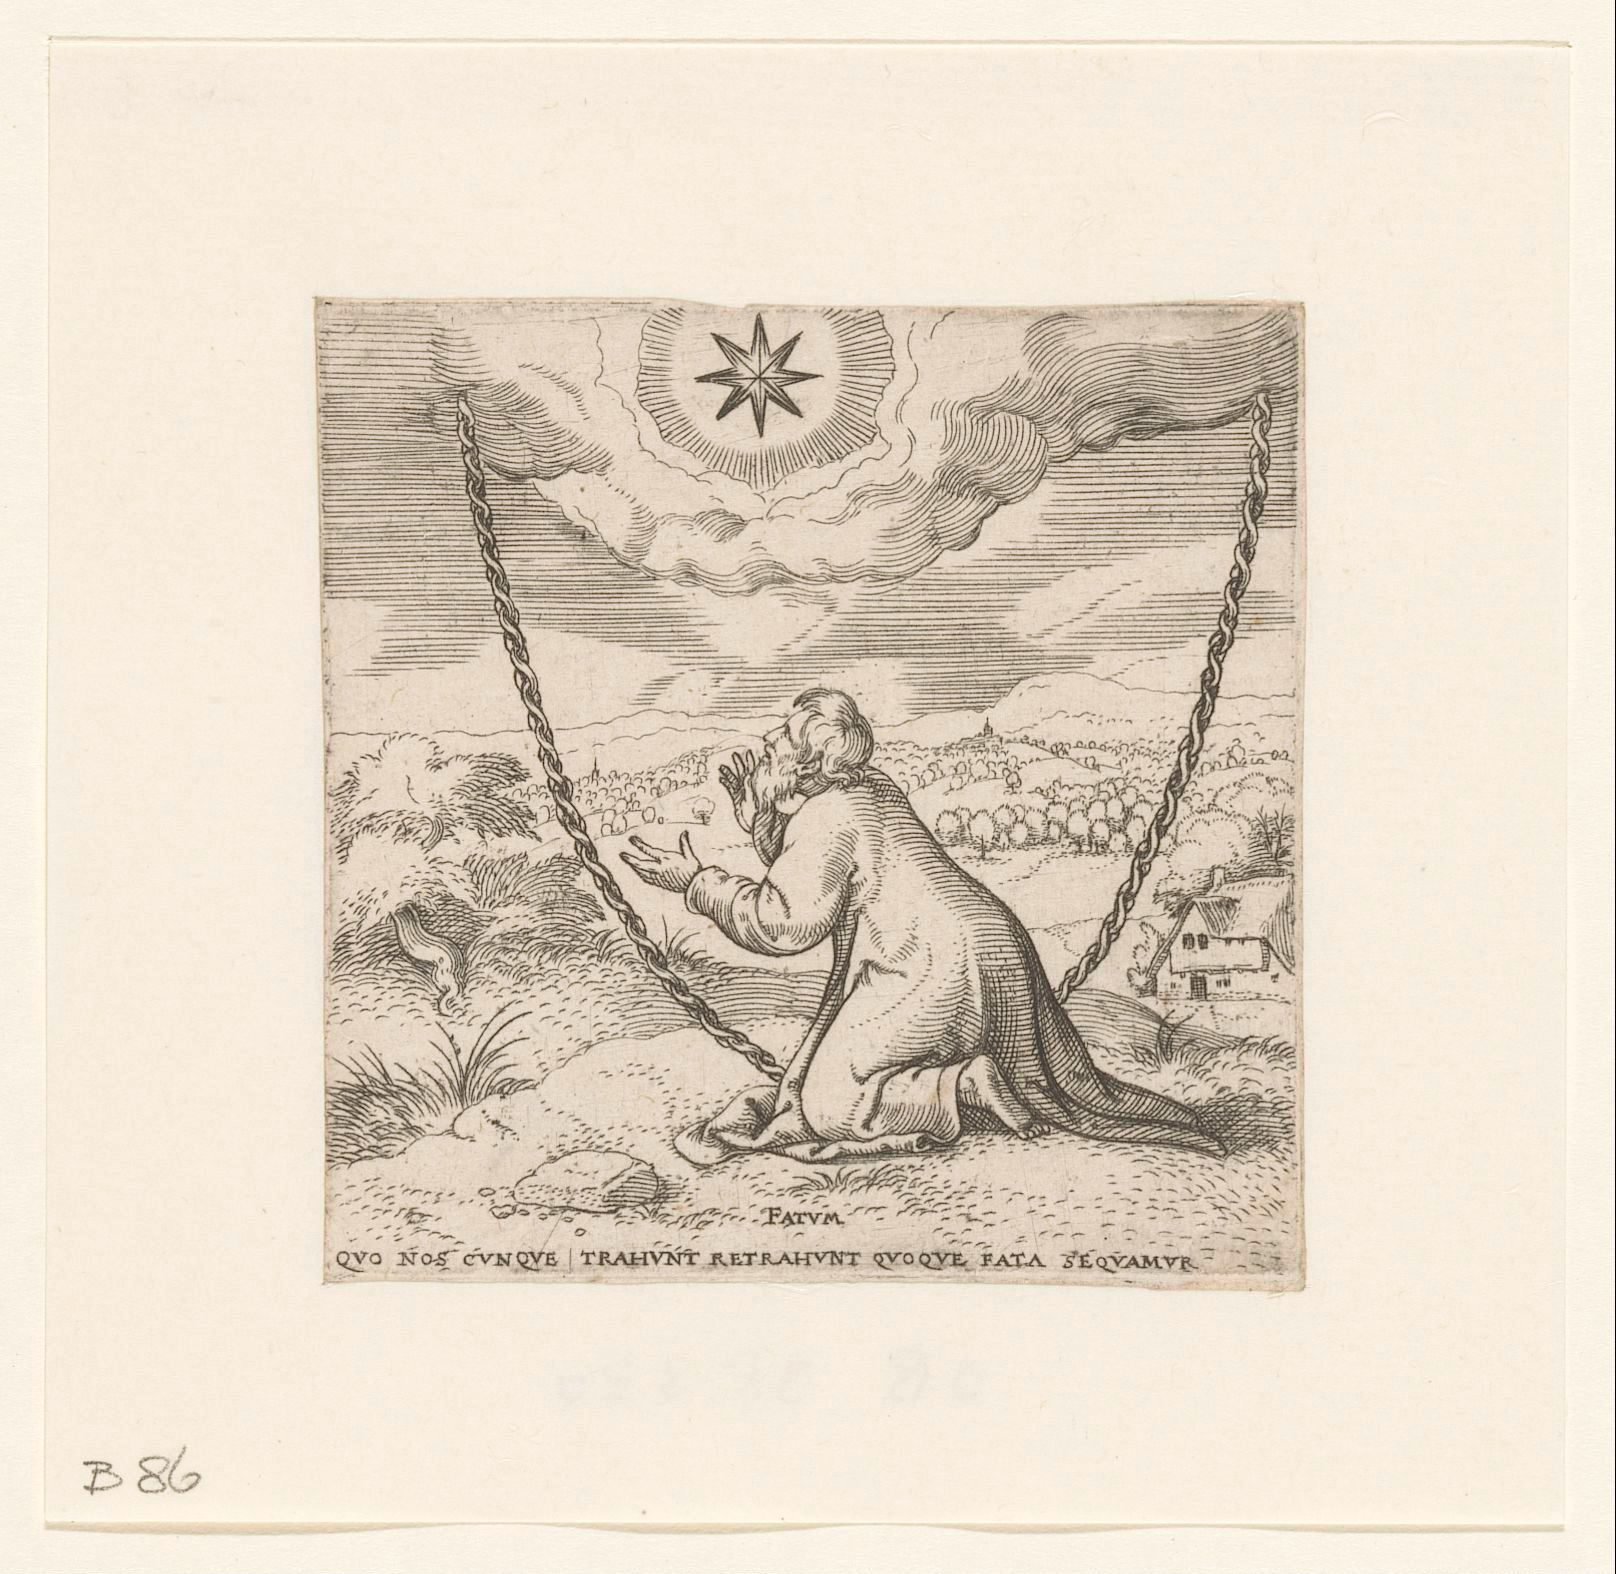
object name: print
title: Emblematische figuren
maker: francesco salviati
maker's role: draughtsman, painter, print maker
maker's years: 1510-1563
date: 1533-1567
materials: paper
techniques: engraving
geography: italy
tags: city-view, and landscape with man-made constructions, luck, fortune, lot; 'fato', 'fortuna', 'fortuna aurea', 'fortuna buona', 'fortuna pacifica overo clemente', 'sorte' (ripa) (+ emblematical representation of concept)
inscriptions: collector's mark: Lugt 240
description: Een man knielend in gebed in een landschap. In de lucht een ster, omgeven door een wolkenpartij waaraan een grote ketting hangt. Onderaan een regel Latijnse tekst.